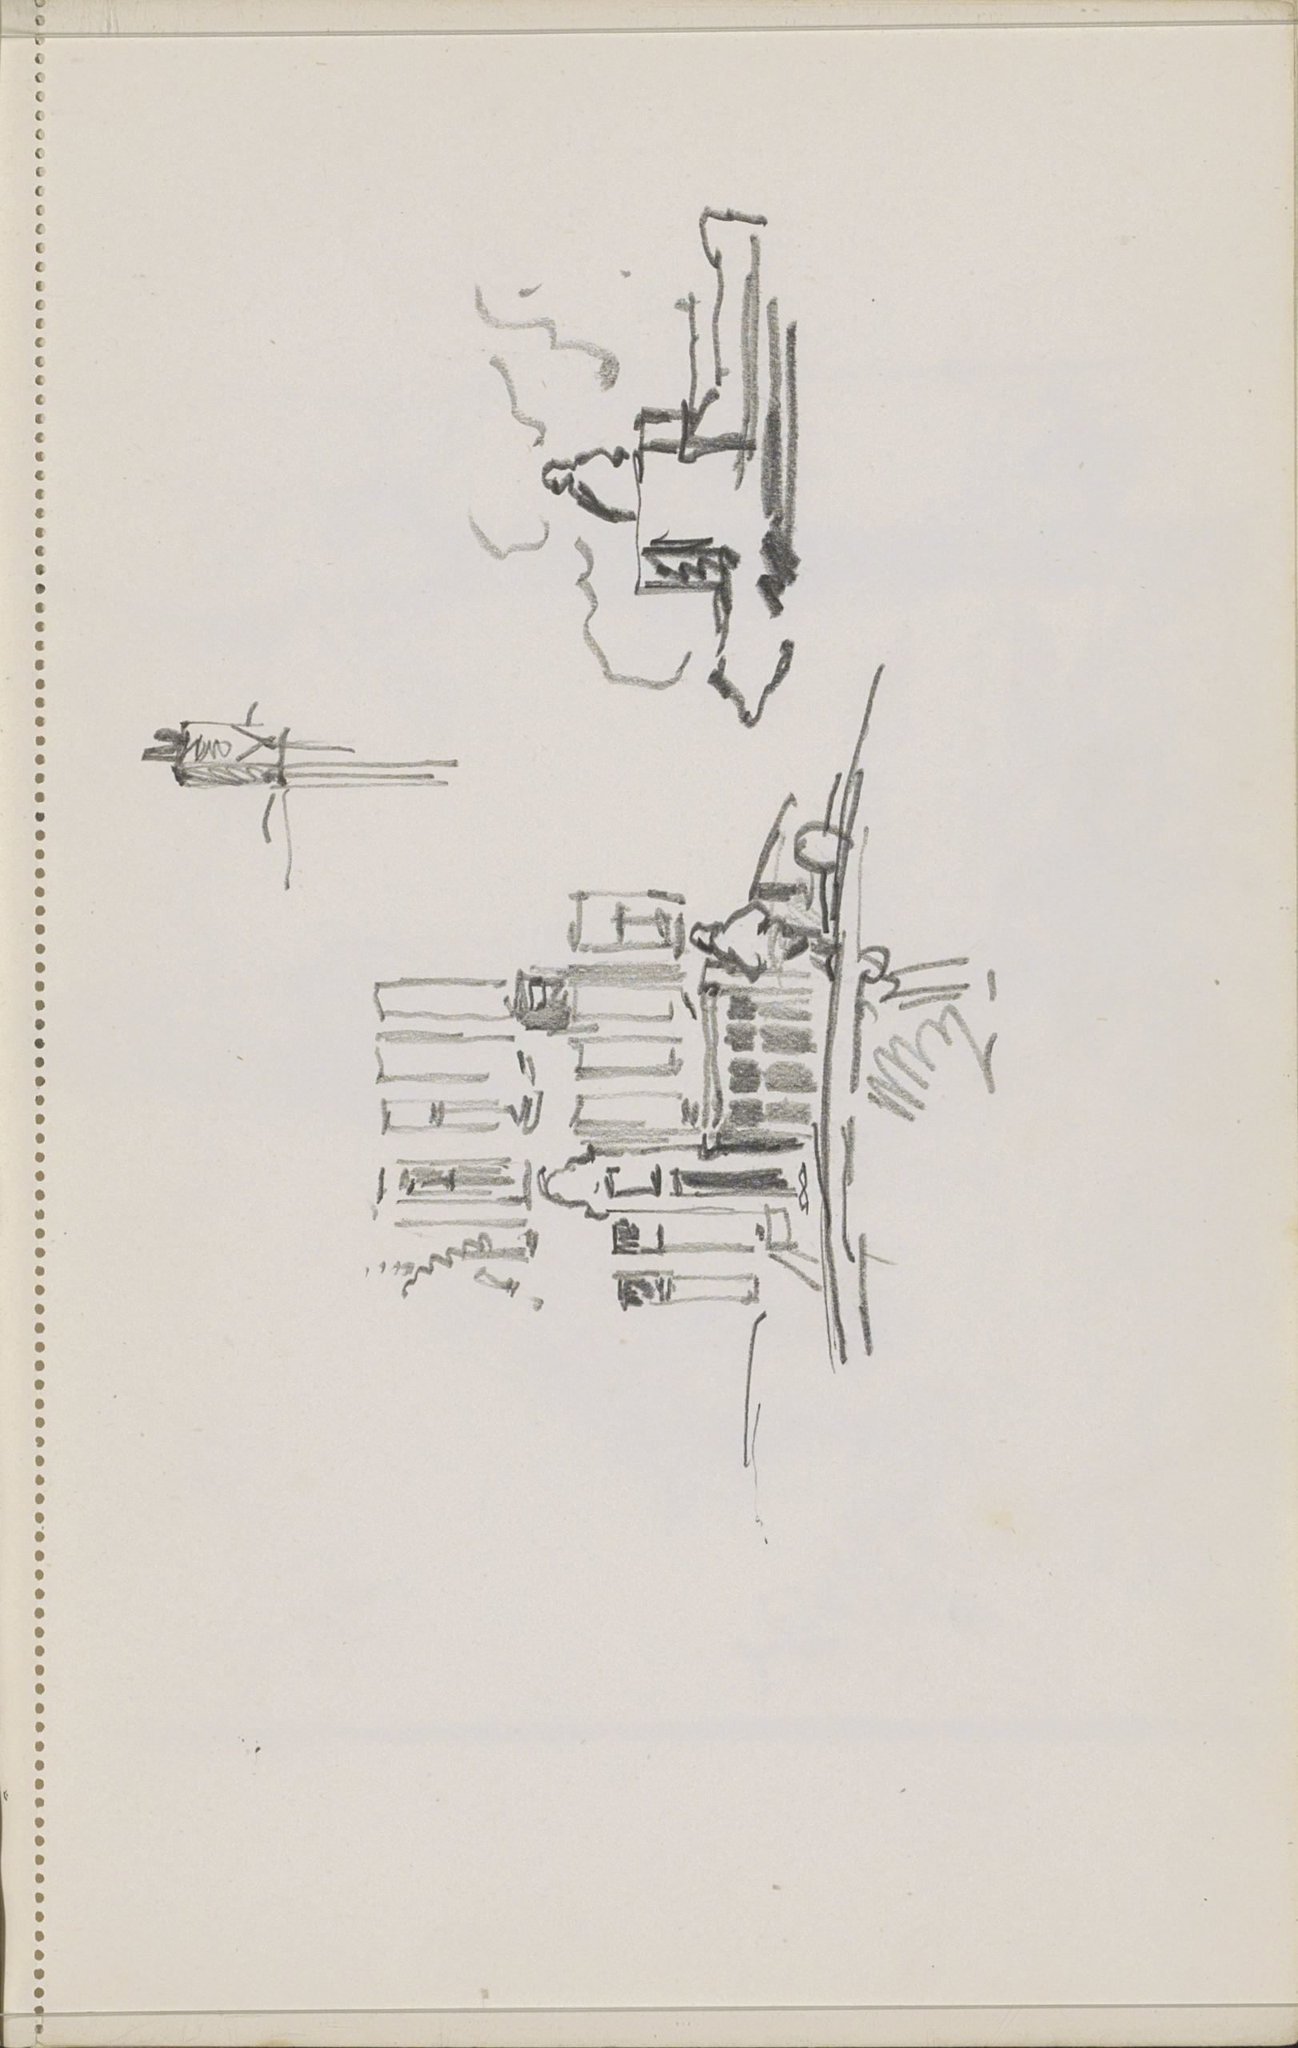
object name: sketchbook leaf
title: Staande figuur op een straat voor een huis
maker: cornelis vreedenburgh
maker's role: draughtsman, print maker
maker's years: 1880-1946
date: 1890-1946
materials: paper, pencil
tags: street (+ city(-scape) with figures, staffage)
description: Tevens een studie van zittende figuur. Blad 31 recto uit een schetsboek met 53 bladen.